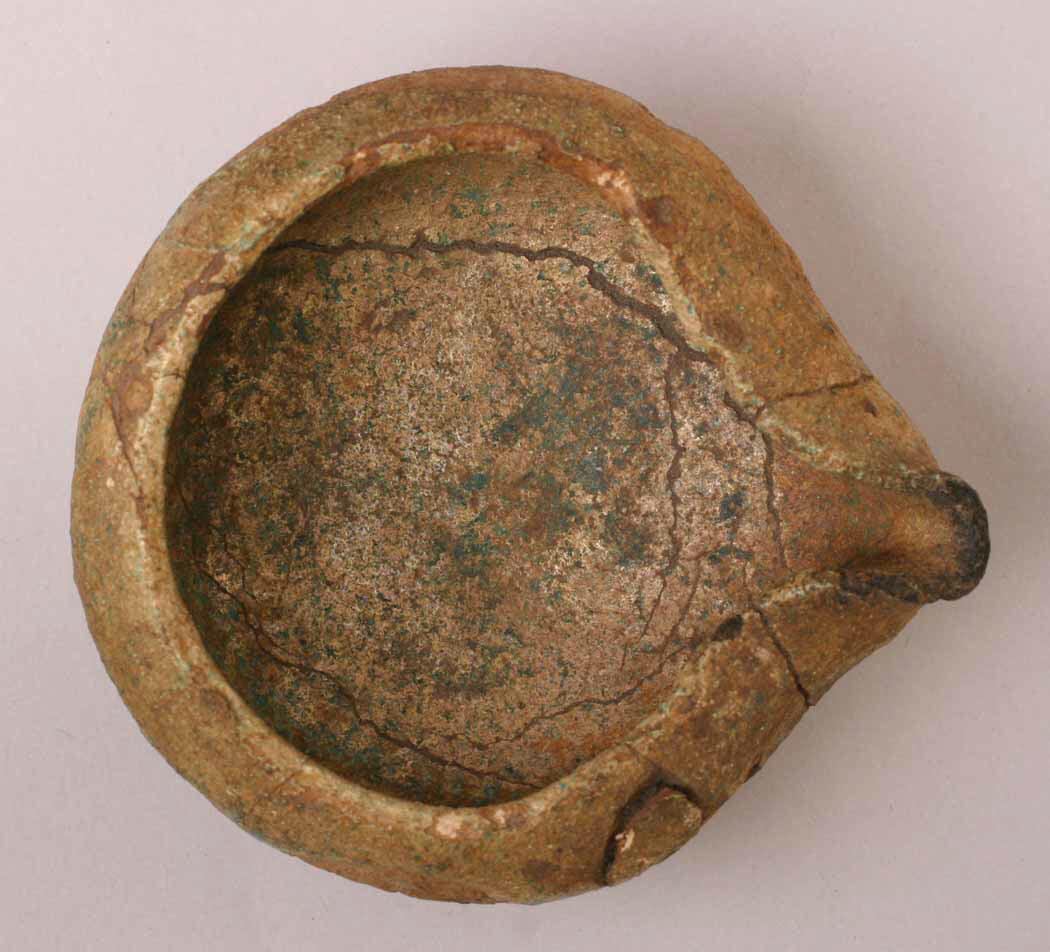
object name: lamp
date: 801-1100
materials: earthenware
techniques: glazing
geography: iran